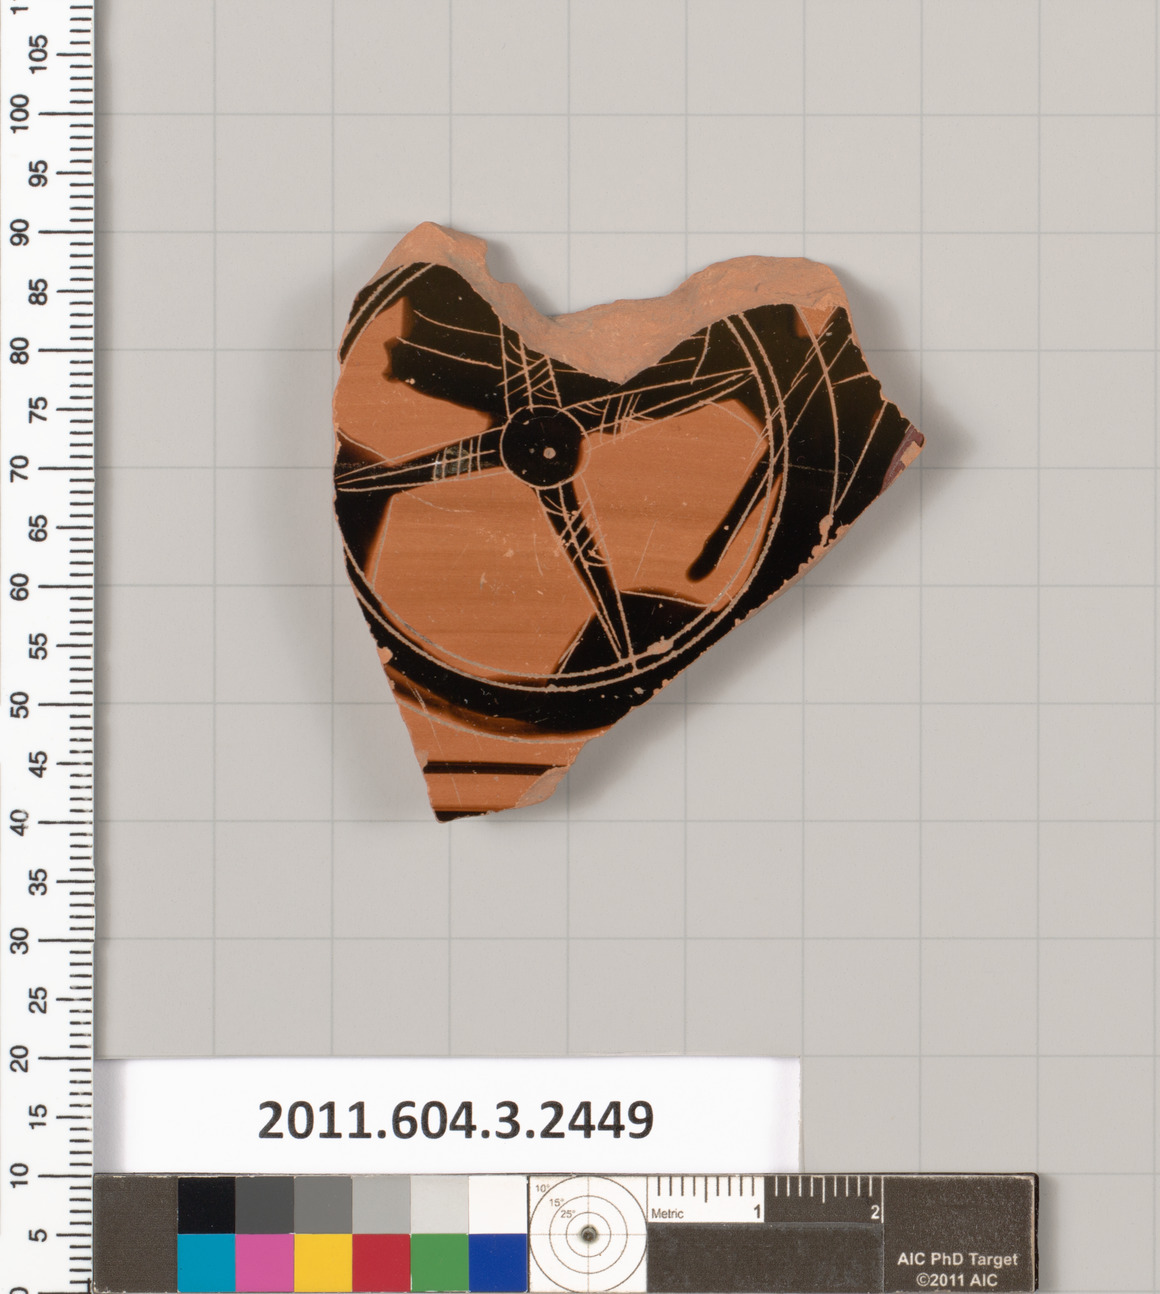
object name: kylix fragment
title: Terracotta rim fragment of a kylix (drinking cup)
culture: greek, attic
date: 525-501 BCE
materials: terracotta